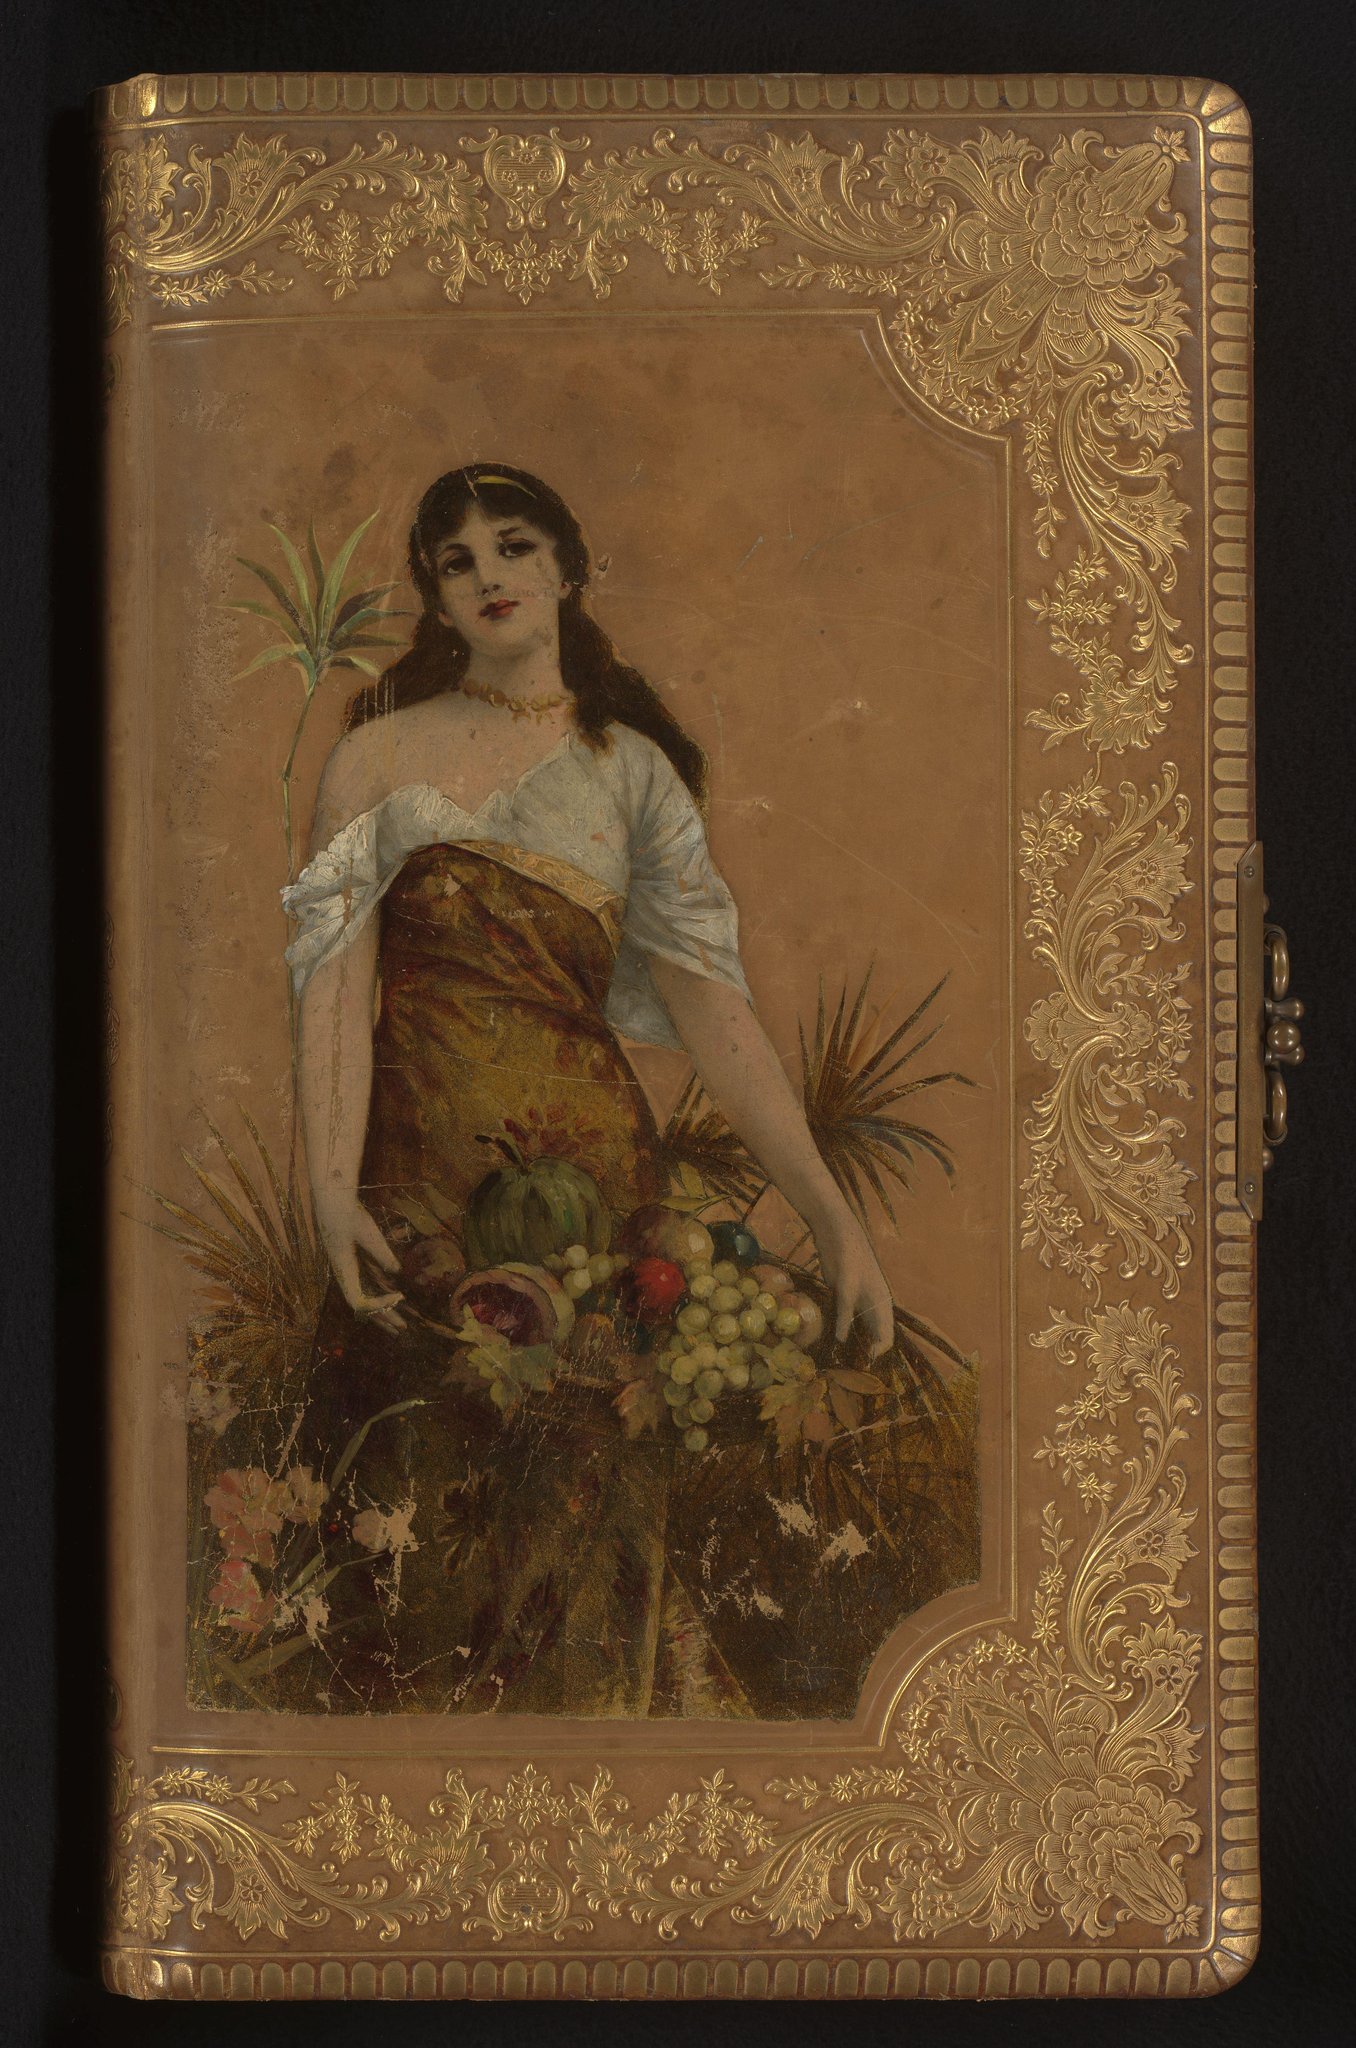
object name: photograph album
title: Fotoalbum (leeg)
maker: Anonymous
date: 1860-1920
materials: cardboard, leather, metal, paper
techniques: lithograph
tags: adult woman, fruits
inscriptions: collector's mark: ‘DIENST/ VERSPREIDE/ RIJKSKOLLEKTIES/ (...) A 978’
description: Fotoalbum met 24 pagina's met ofwel twee met groene en gouden lijnen omkaderde passe-partouts voor kabinetfoto's, ofwel 6 met groene en gouden lijnen omkaderde passe-partouts voor cartes-de-visite. In totaal is er in het album plaats voor 24 kabinetfoto's en 72 cartes-de-visite. Op een albumblad staat de naam Marie Otte handgeschreven, wat vermoedelijk betekent dat het album wel foto's heeft bevat en is leeggemaakt.